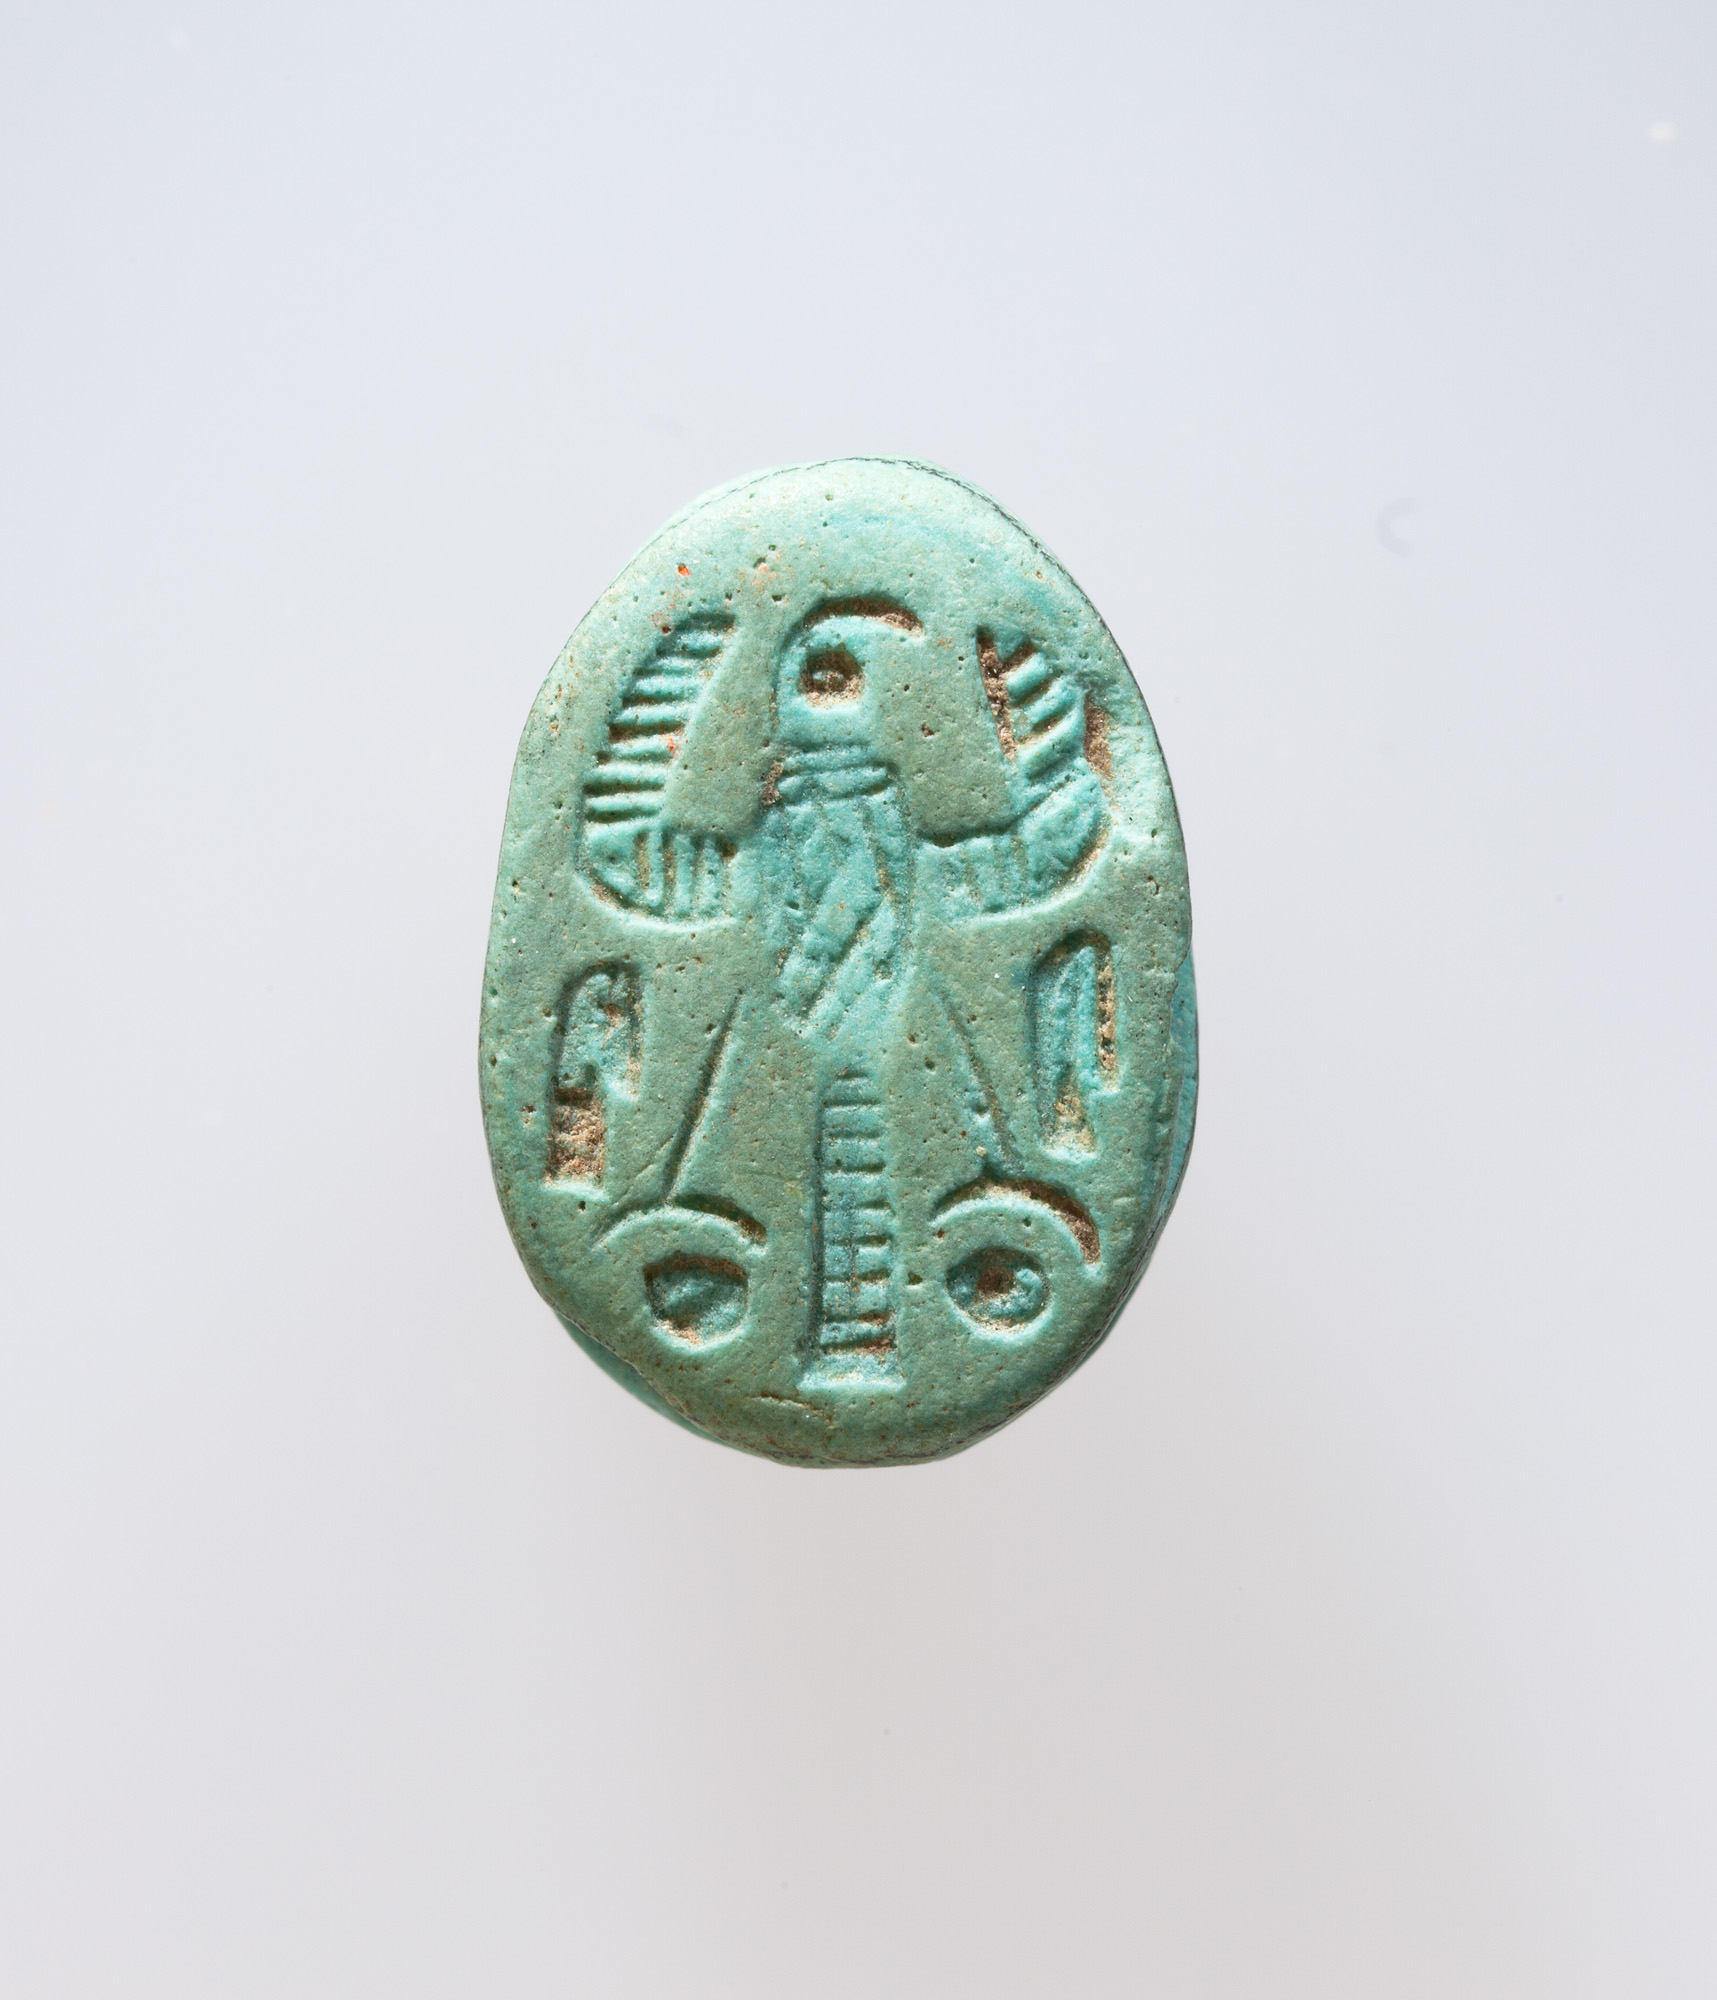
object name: scarab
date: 1479-1458 BCE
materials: faience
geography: egypt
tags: hieroglyphs,scarabs